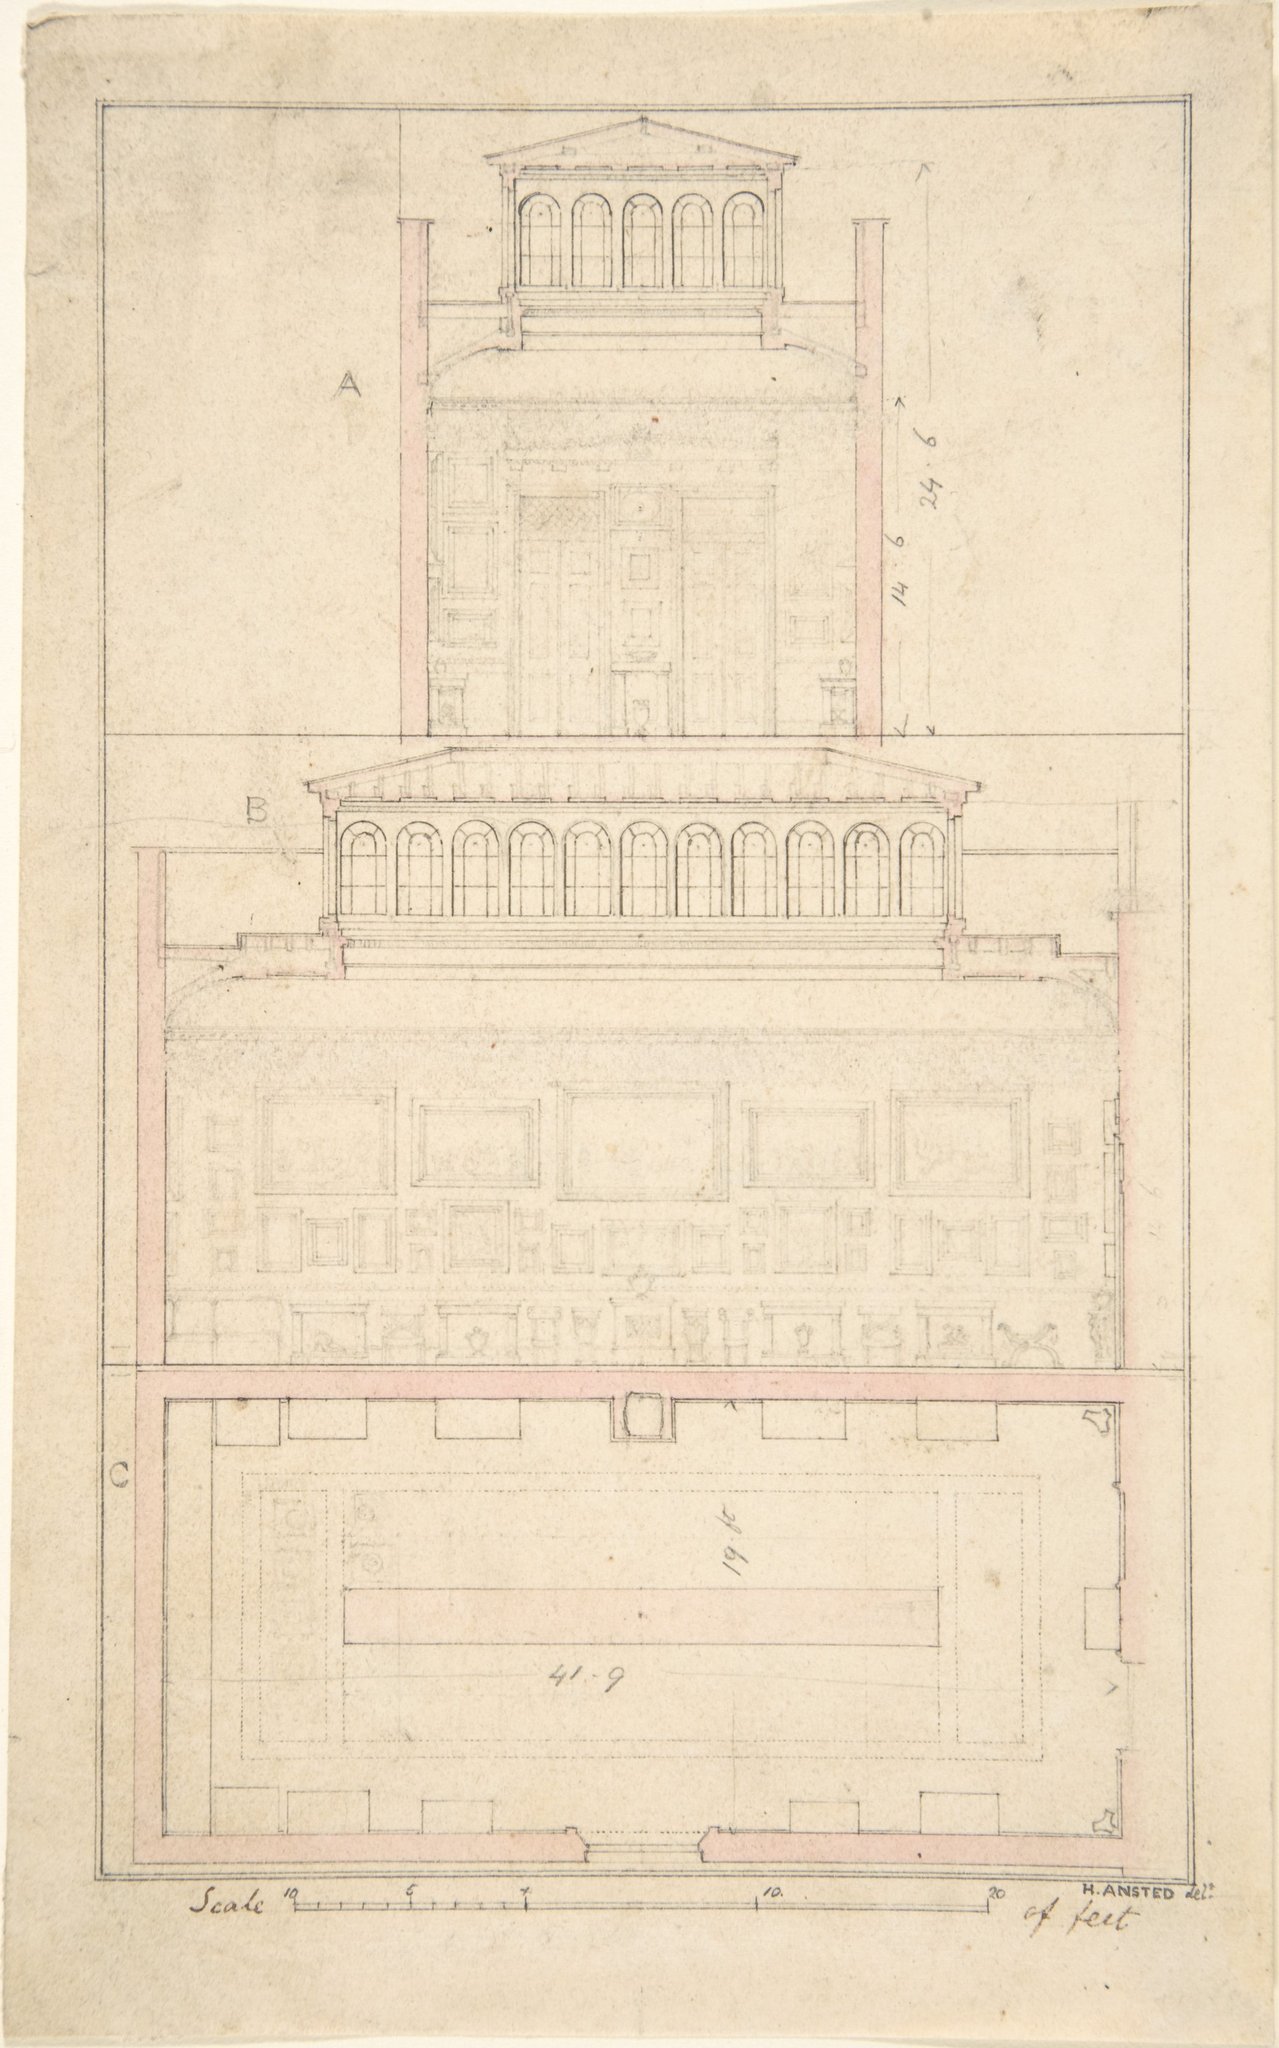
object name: drawing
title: Mansion of Thomas Hope, Flemish Picture Gallery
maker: h. ansted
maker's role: artist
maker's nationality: british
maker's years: 1800-1850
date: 1824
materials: graphite, ink, watercolor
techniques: pen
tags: architecture,houses